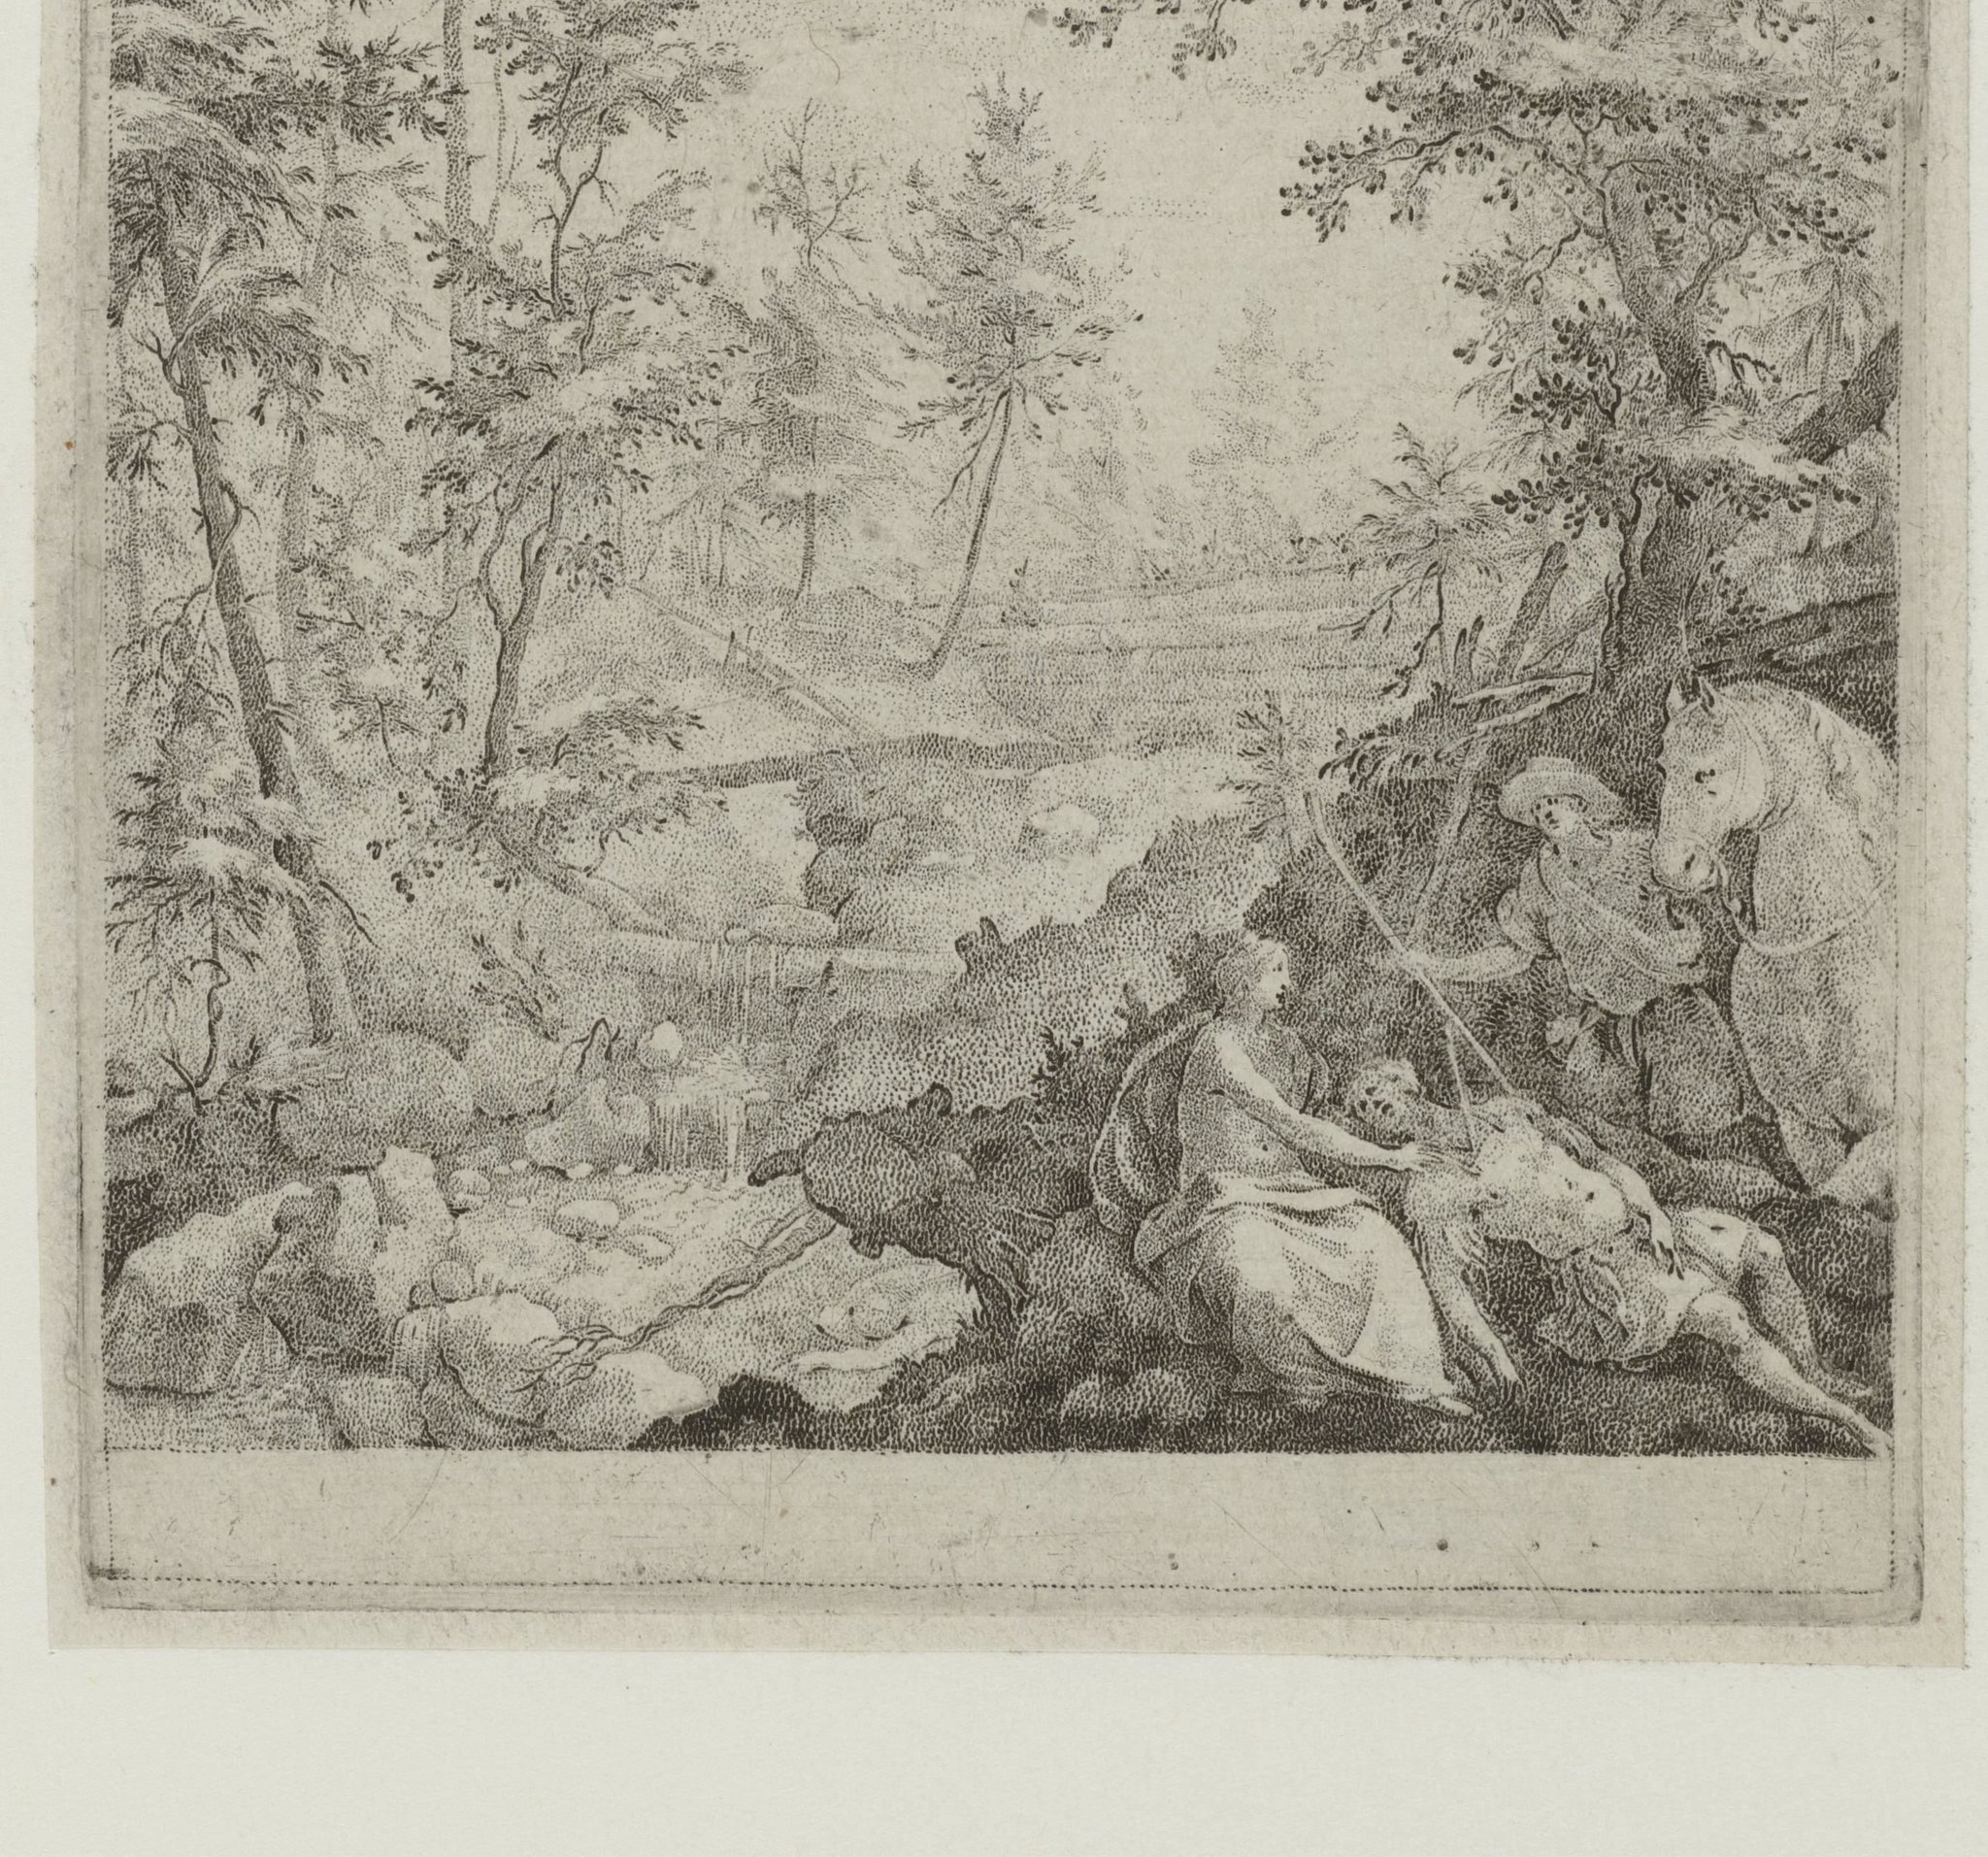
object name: print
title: Tancred Tended by Erminia and Vafrino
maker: paulus willemsz. van vianen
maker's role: draughtsman, jeweler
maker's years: 1570-1614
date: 1580-1613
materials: paper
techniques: engraving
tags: erminia, tancred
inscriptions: collector's mark: Lugt 2228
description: This print with a scene from the epic poem Gerusalemme liberata (Jerusalem delivered) was made with a goldsmith’s tool. The image is created by means of a punch or a matting wheel, which makes countless tiny pits in the copper plate. When the plate is covered with ink, the pits fill up, leaving black stipples on the paper when the print is pulled.